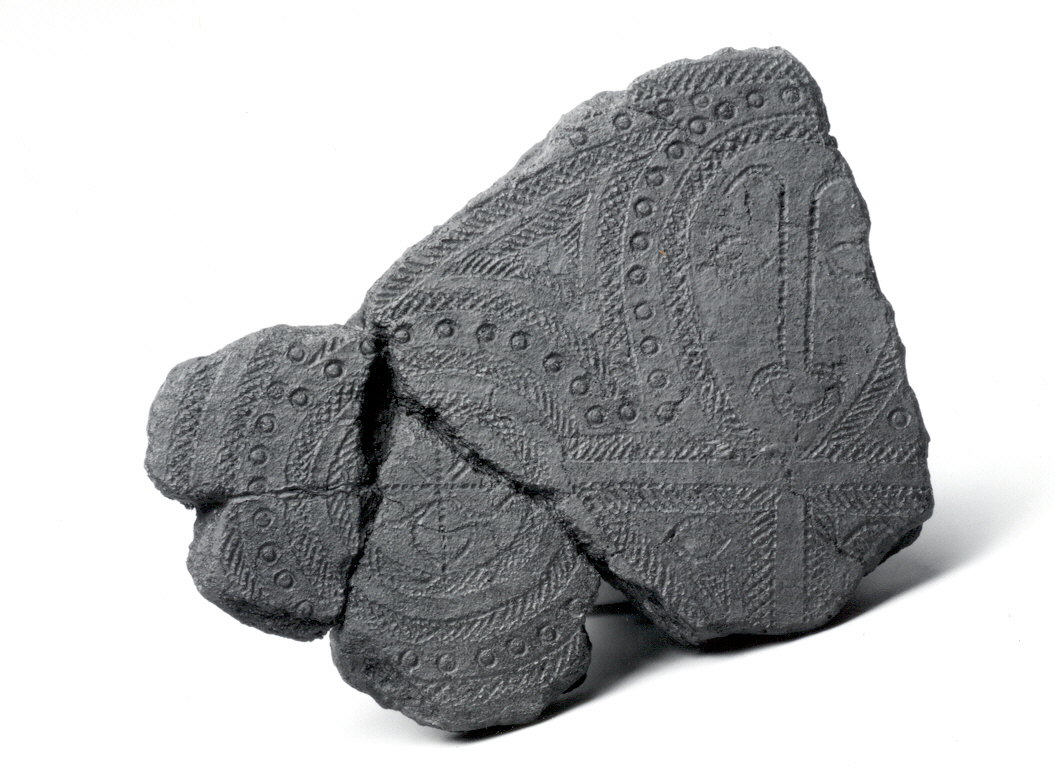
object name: cast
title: Cast of a Pot Sherd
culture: lapita people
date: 1934-1966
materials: plaster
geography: solomon islands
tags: faces